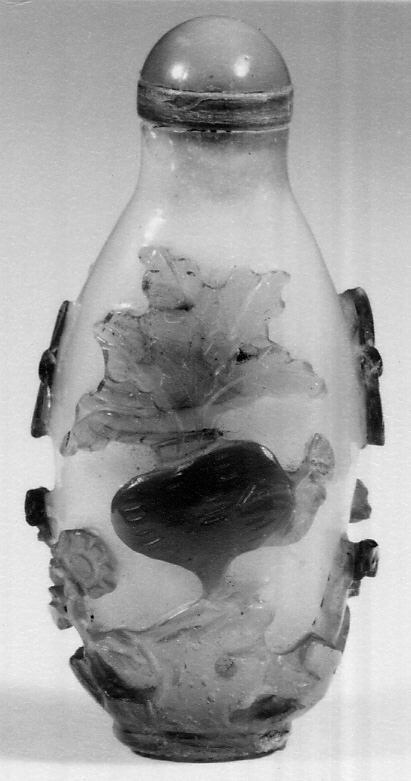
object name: snuff bottle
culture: chinese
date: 1801-1900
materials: glass